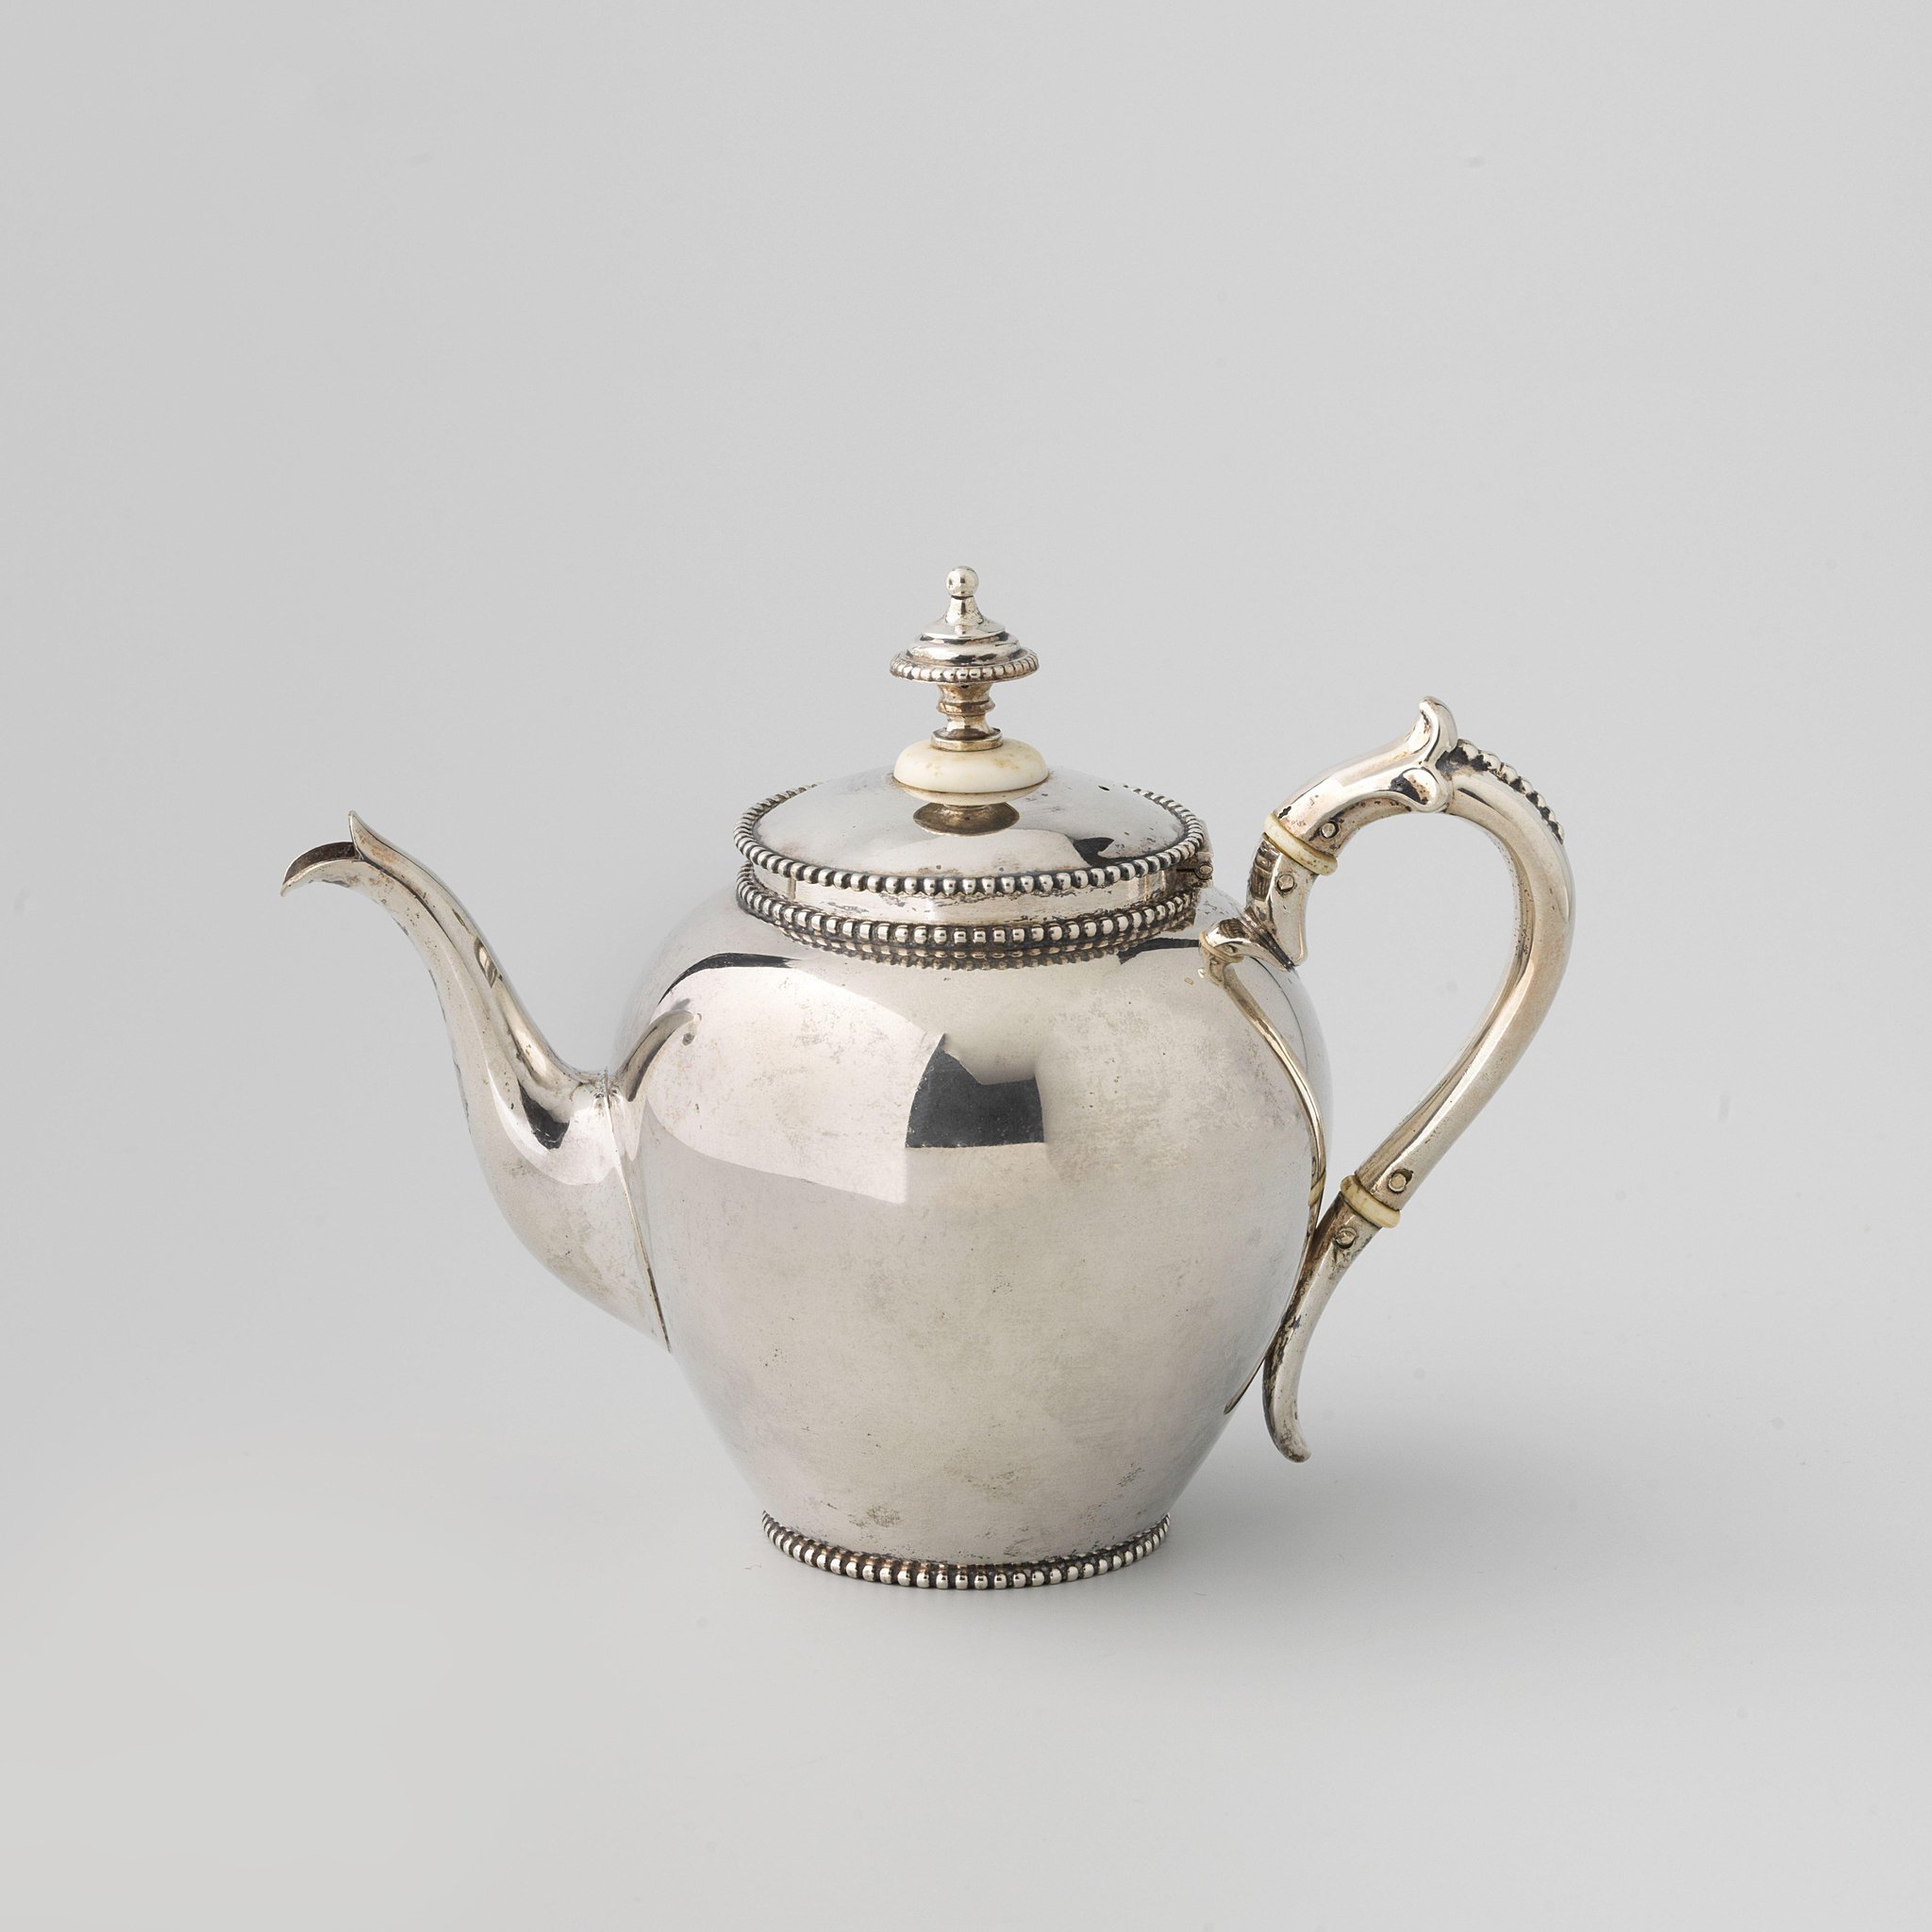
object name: teapot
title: Trekpot van zilver, gestrekt bolvormig en afgezet met parelranden.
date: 1886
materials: silver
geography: voorschoten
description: Trekpot van zilver. Gestrekt bolvormig en afgezet met parelranden.